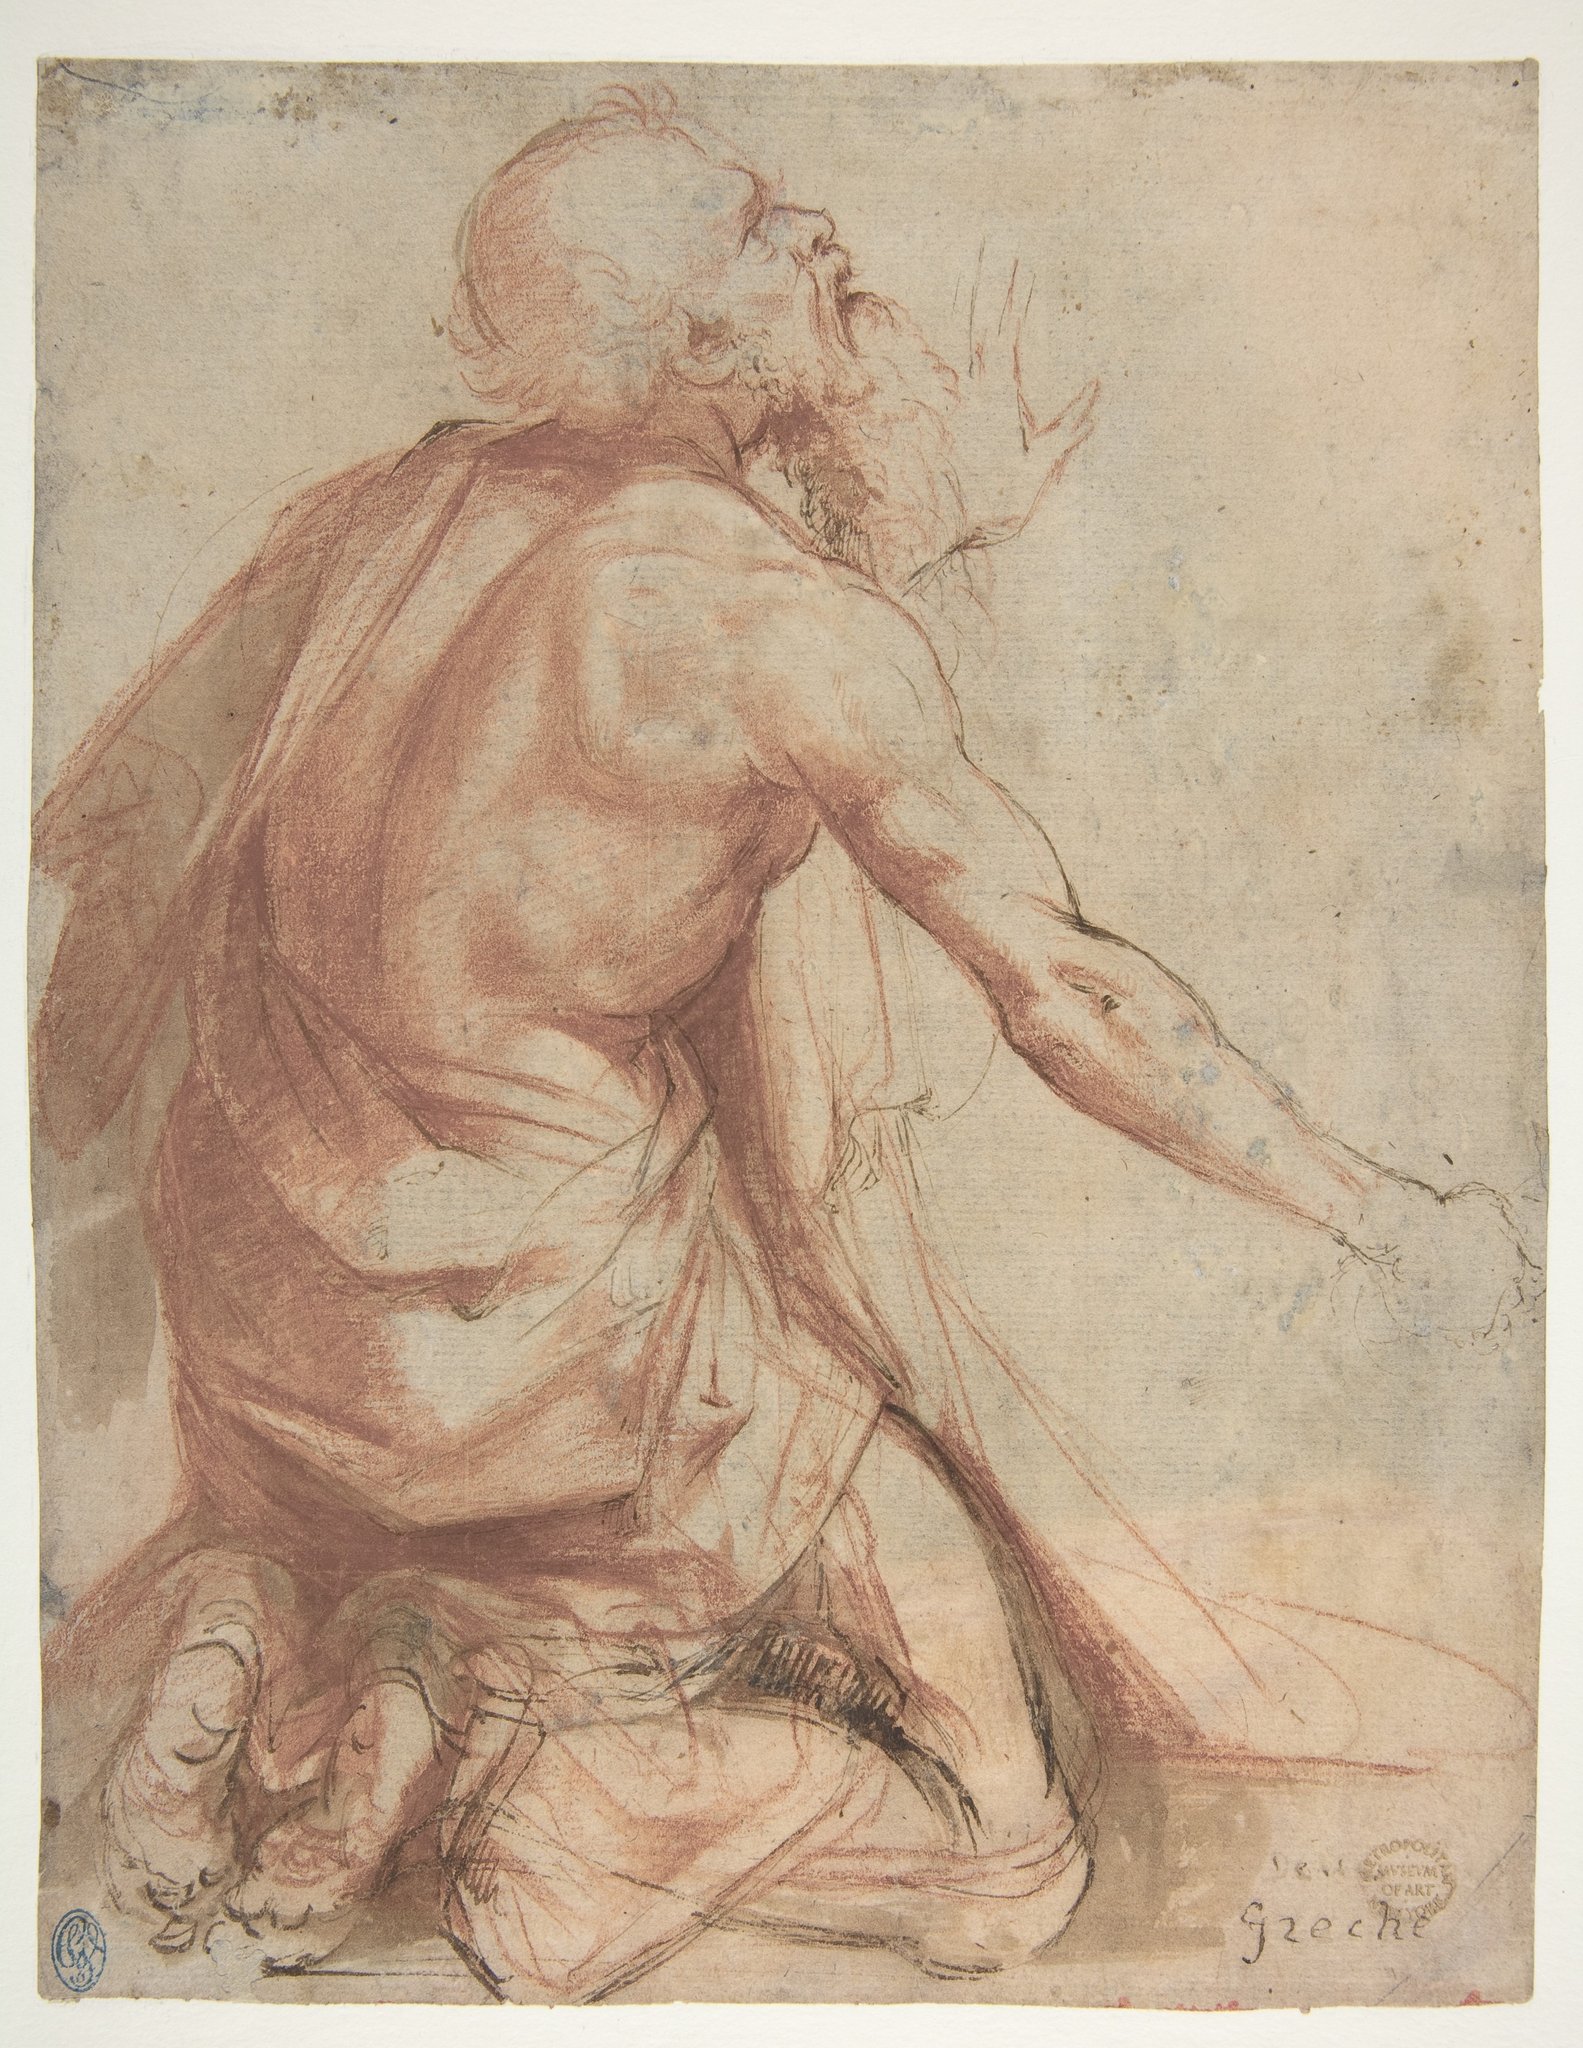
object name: drawing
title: Kneeling Bearded Old Man (recto); Section of a Draped Limb and Sketches (verso)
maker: nosadella (giovanni francesco bezzi)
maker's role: artist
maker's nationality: italian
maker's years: 1500-1571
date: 1500-1571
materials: chalk, charcoal, ink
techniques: brush, highlighting, pen, transfer, wash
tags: men